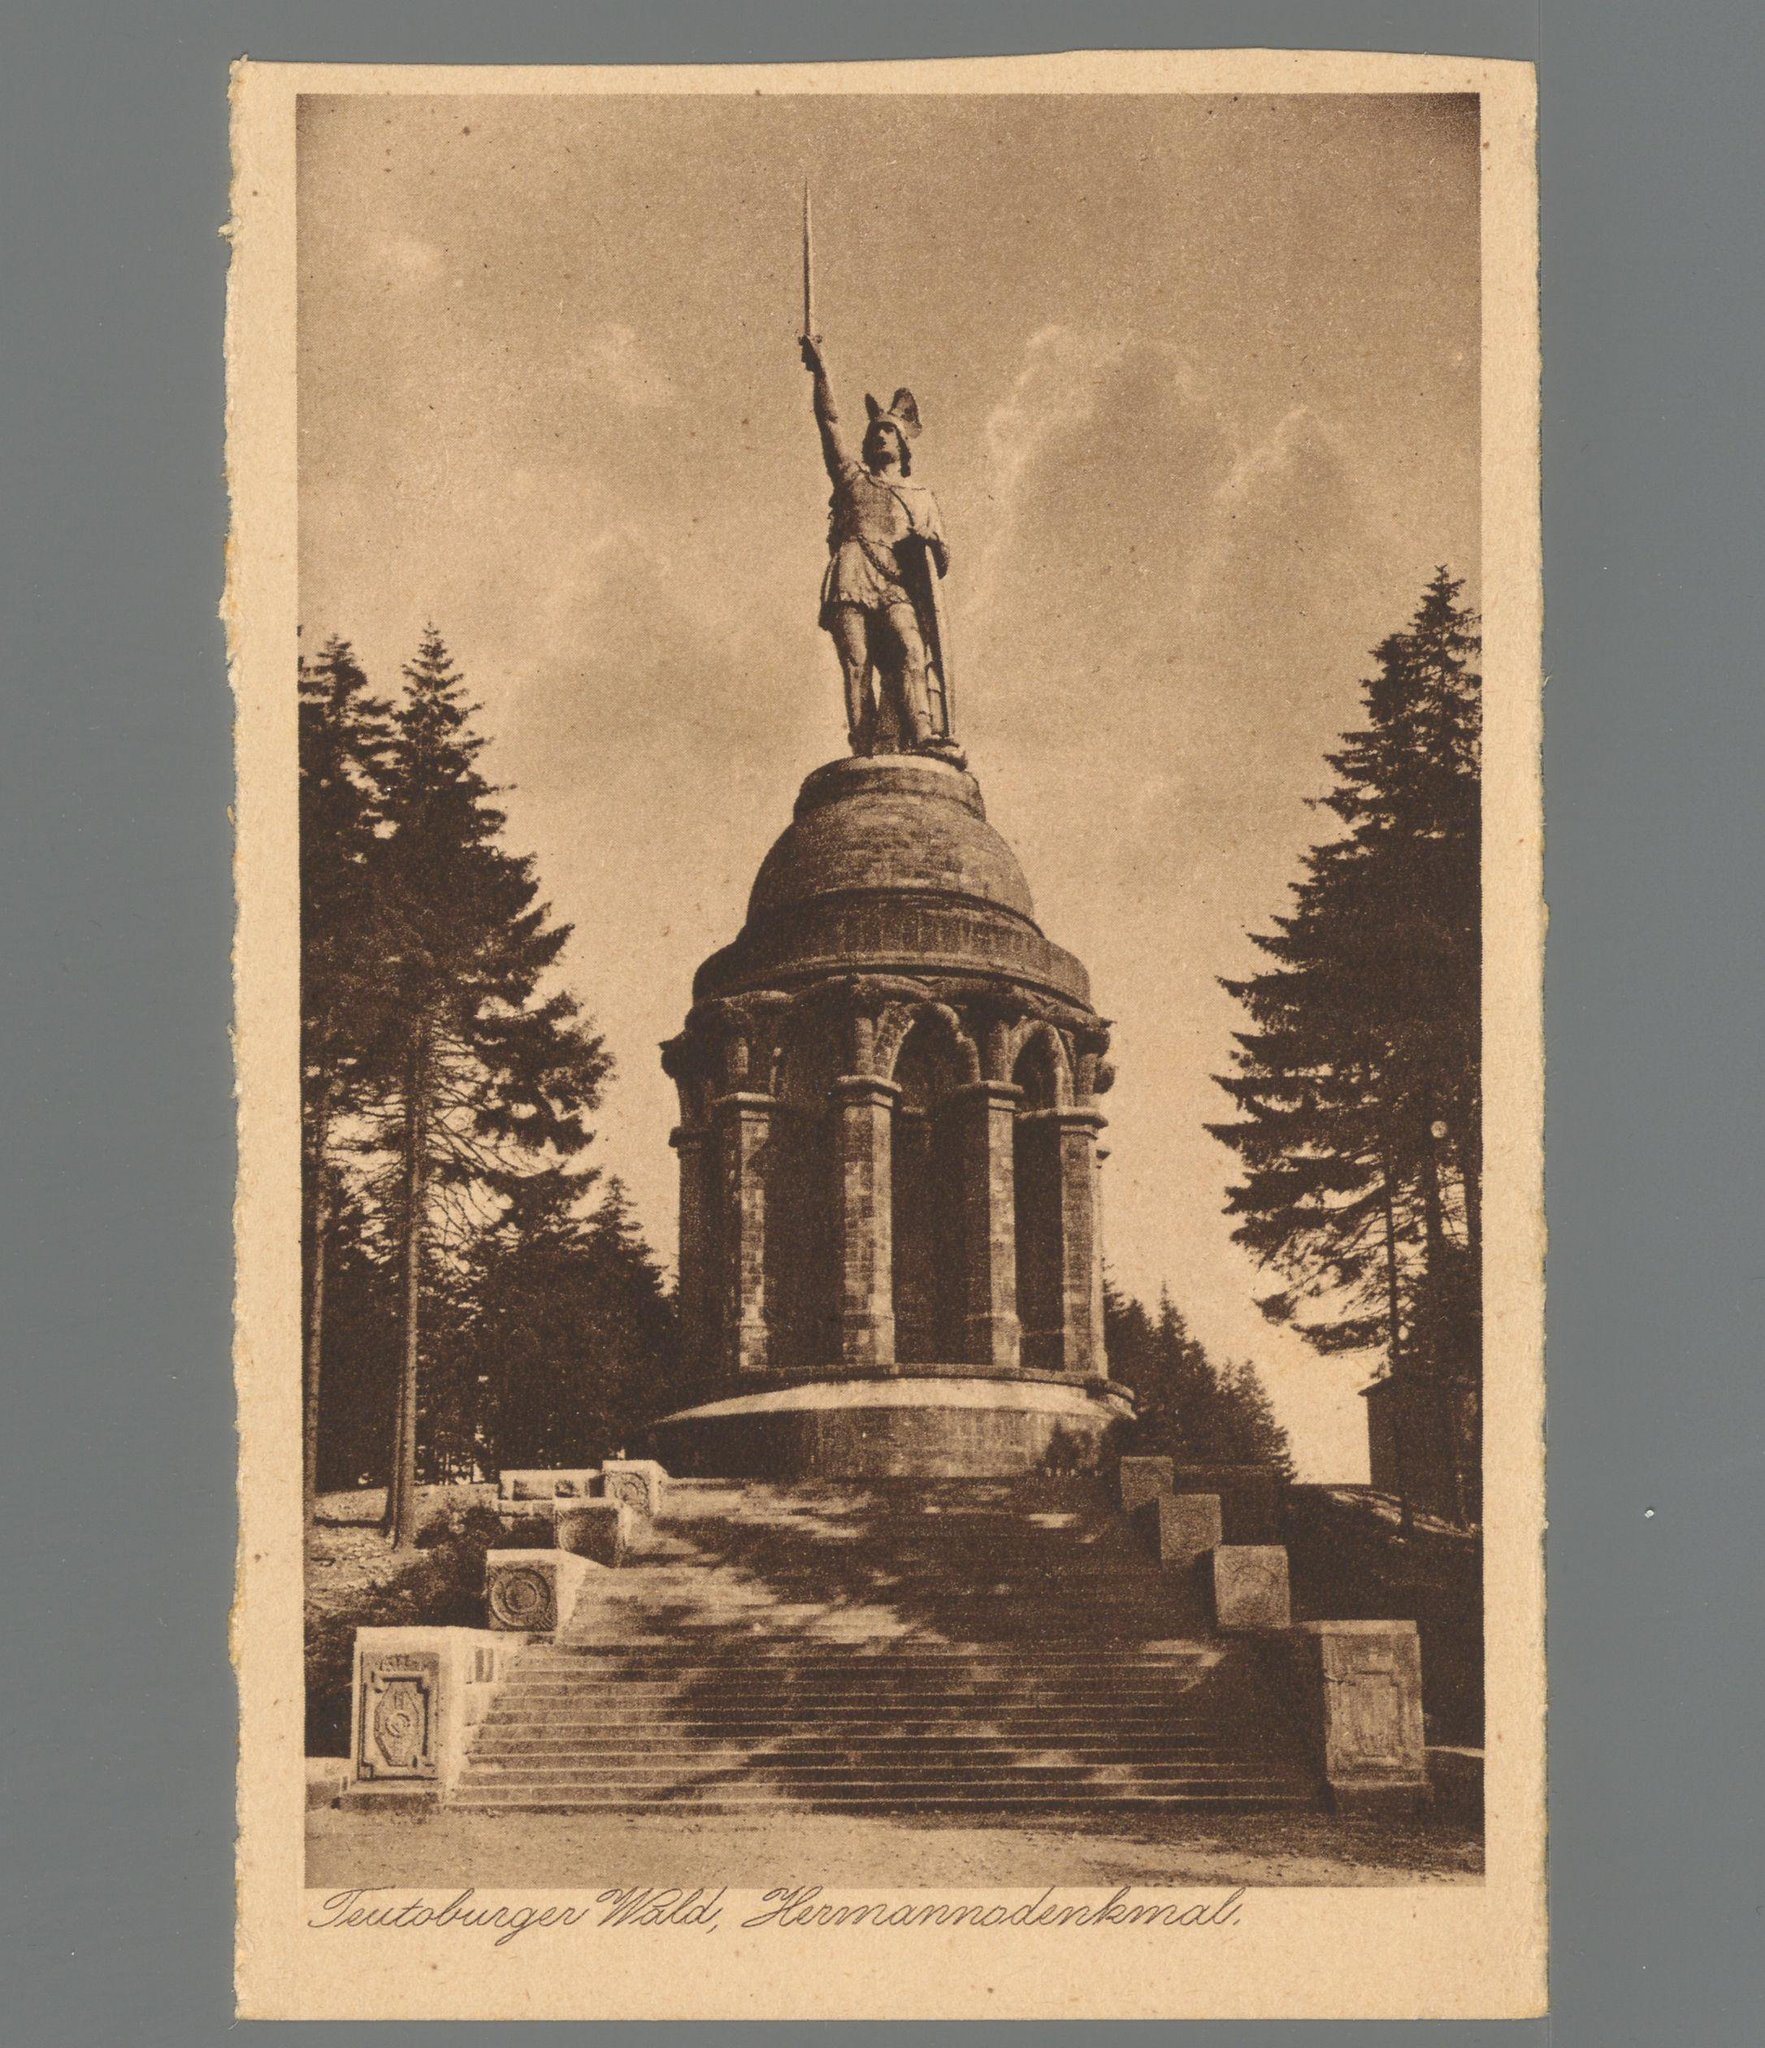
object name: ansichtkaart, prentbriefkaart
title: Teutoburger Wald. Hermannsdenkmal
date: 1905-1930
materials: cardboard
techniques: rotogravure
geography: detmold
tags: monument, statue